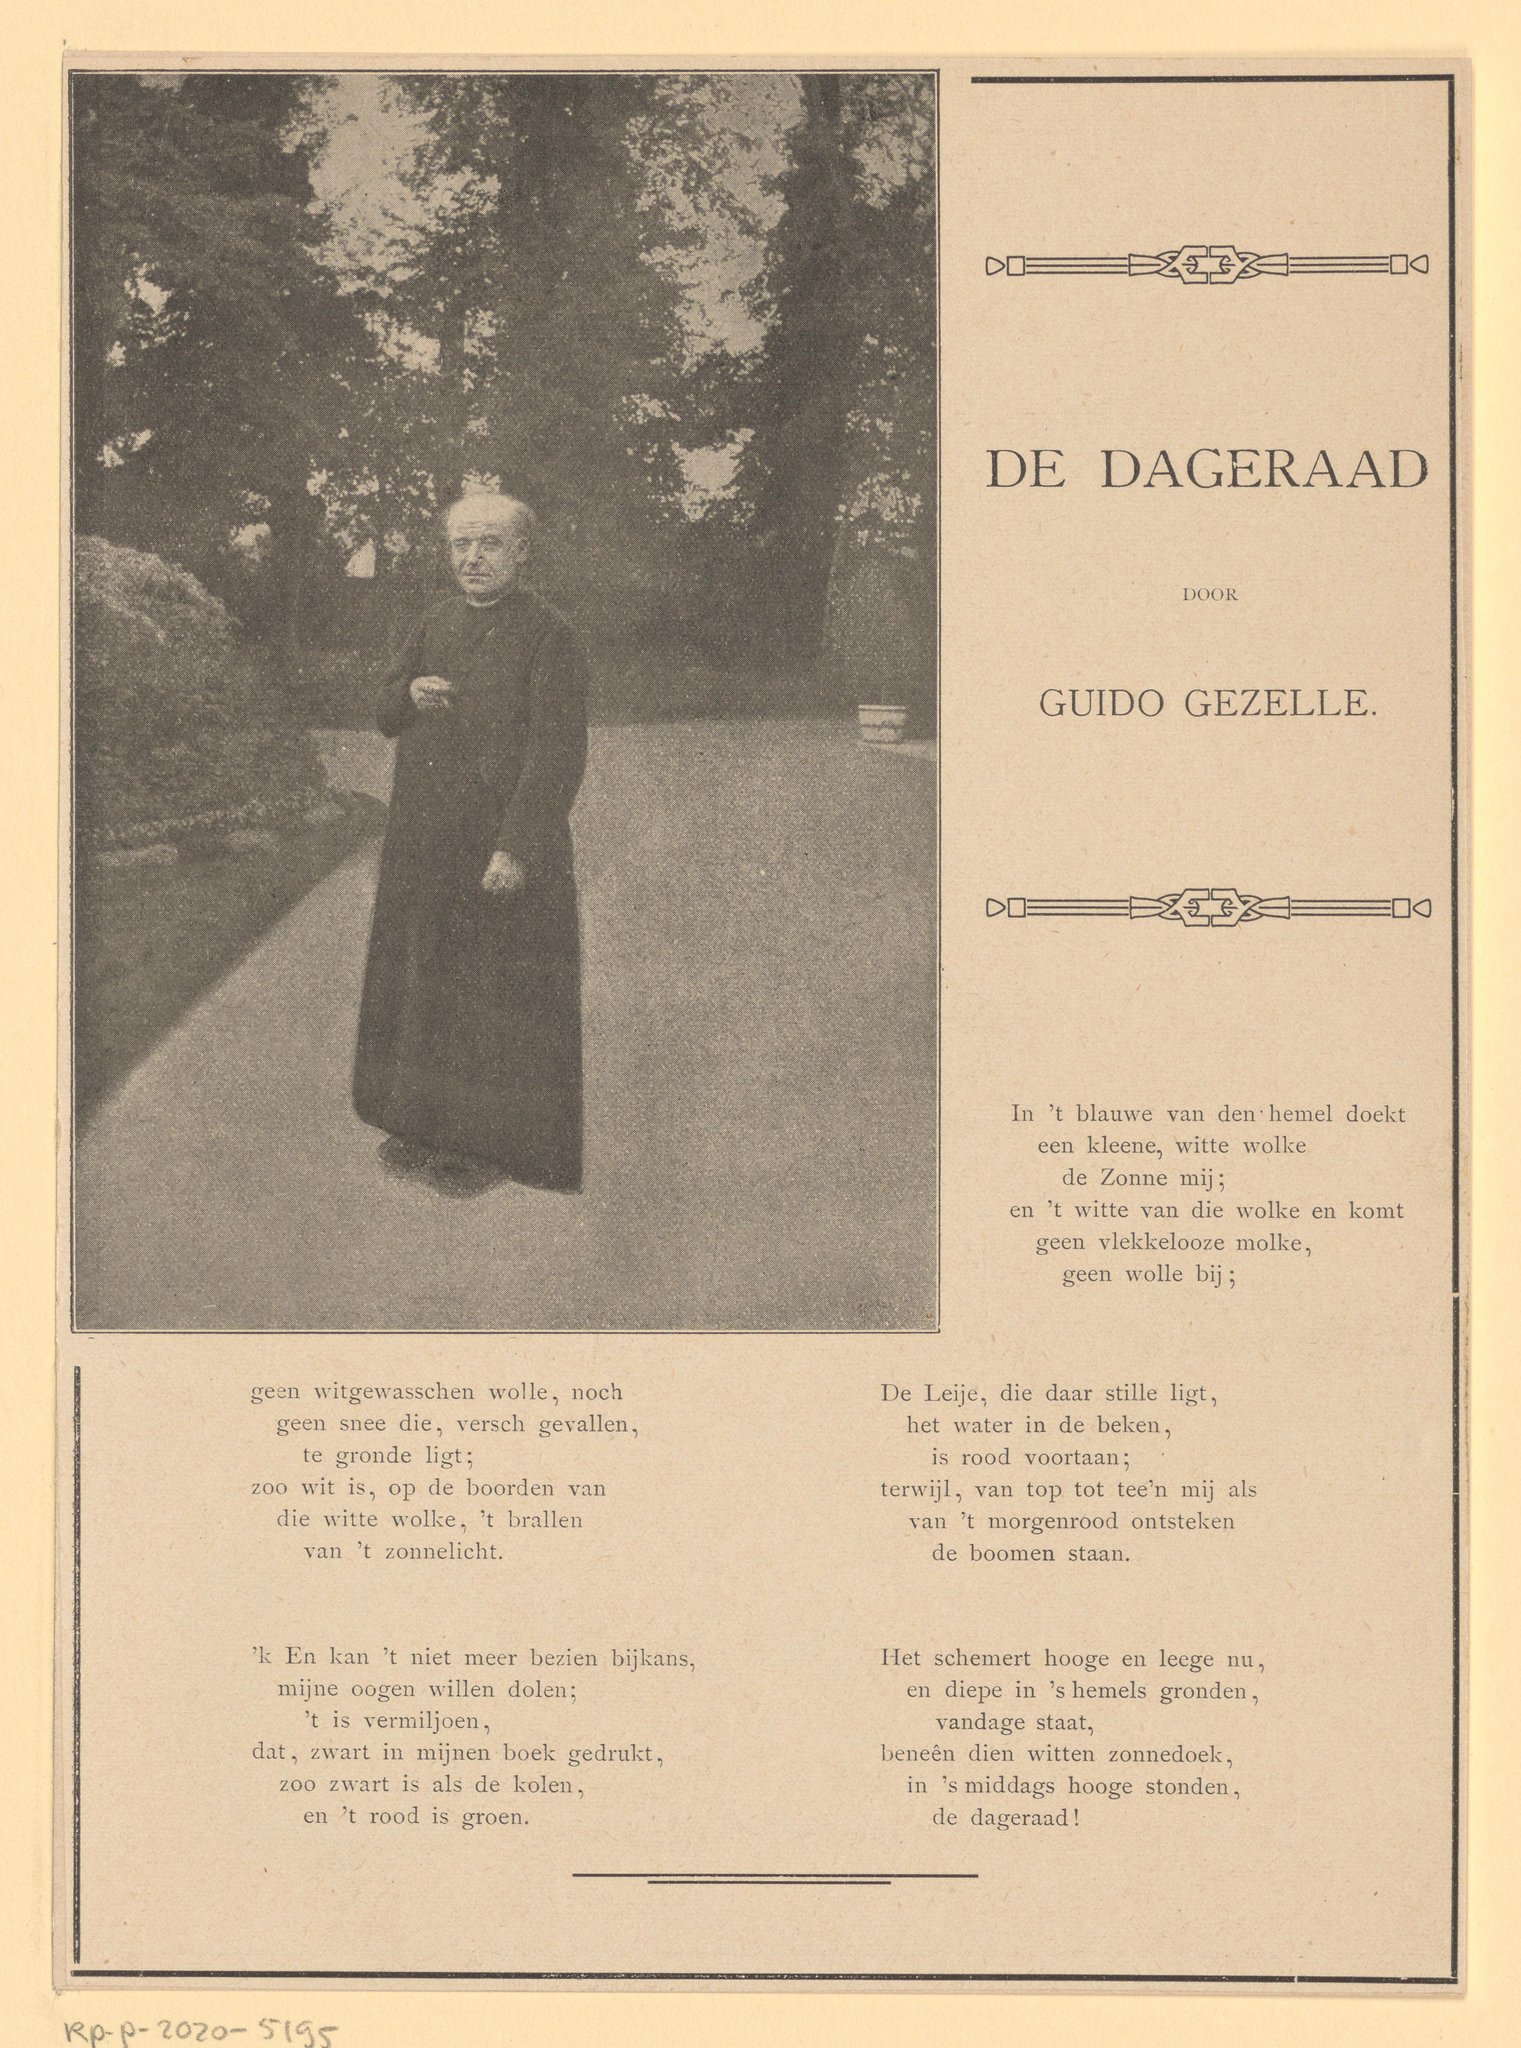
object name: photomechanical print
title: Portret van Guido Gezelle met een gedicht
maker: Anonymous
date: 1847-1899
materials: paper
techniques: letterpress printing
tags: bruges, priest, guido gezelle, historical persons, writer, poet, author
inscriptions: : ‘De Dageraard/ door/ Guido Gezelle./ (...) in 's middags hooge stronden,/ de dageraard!’